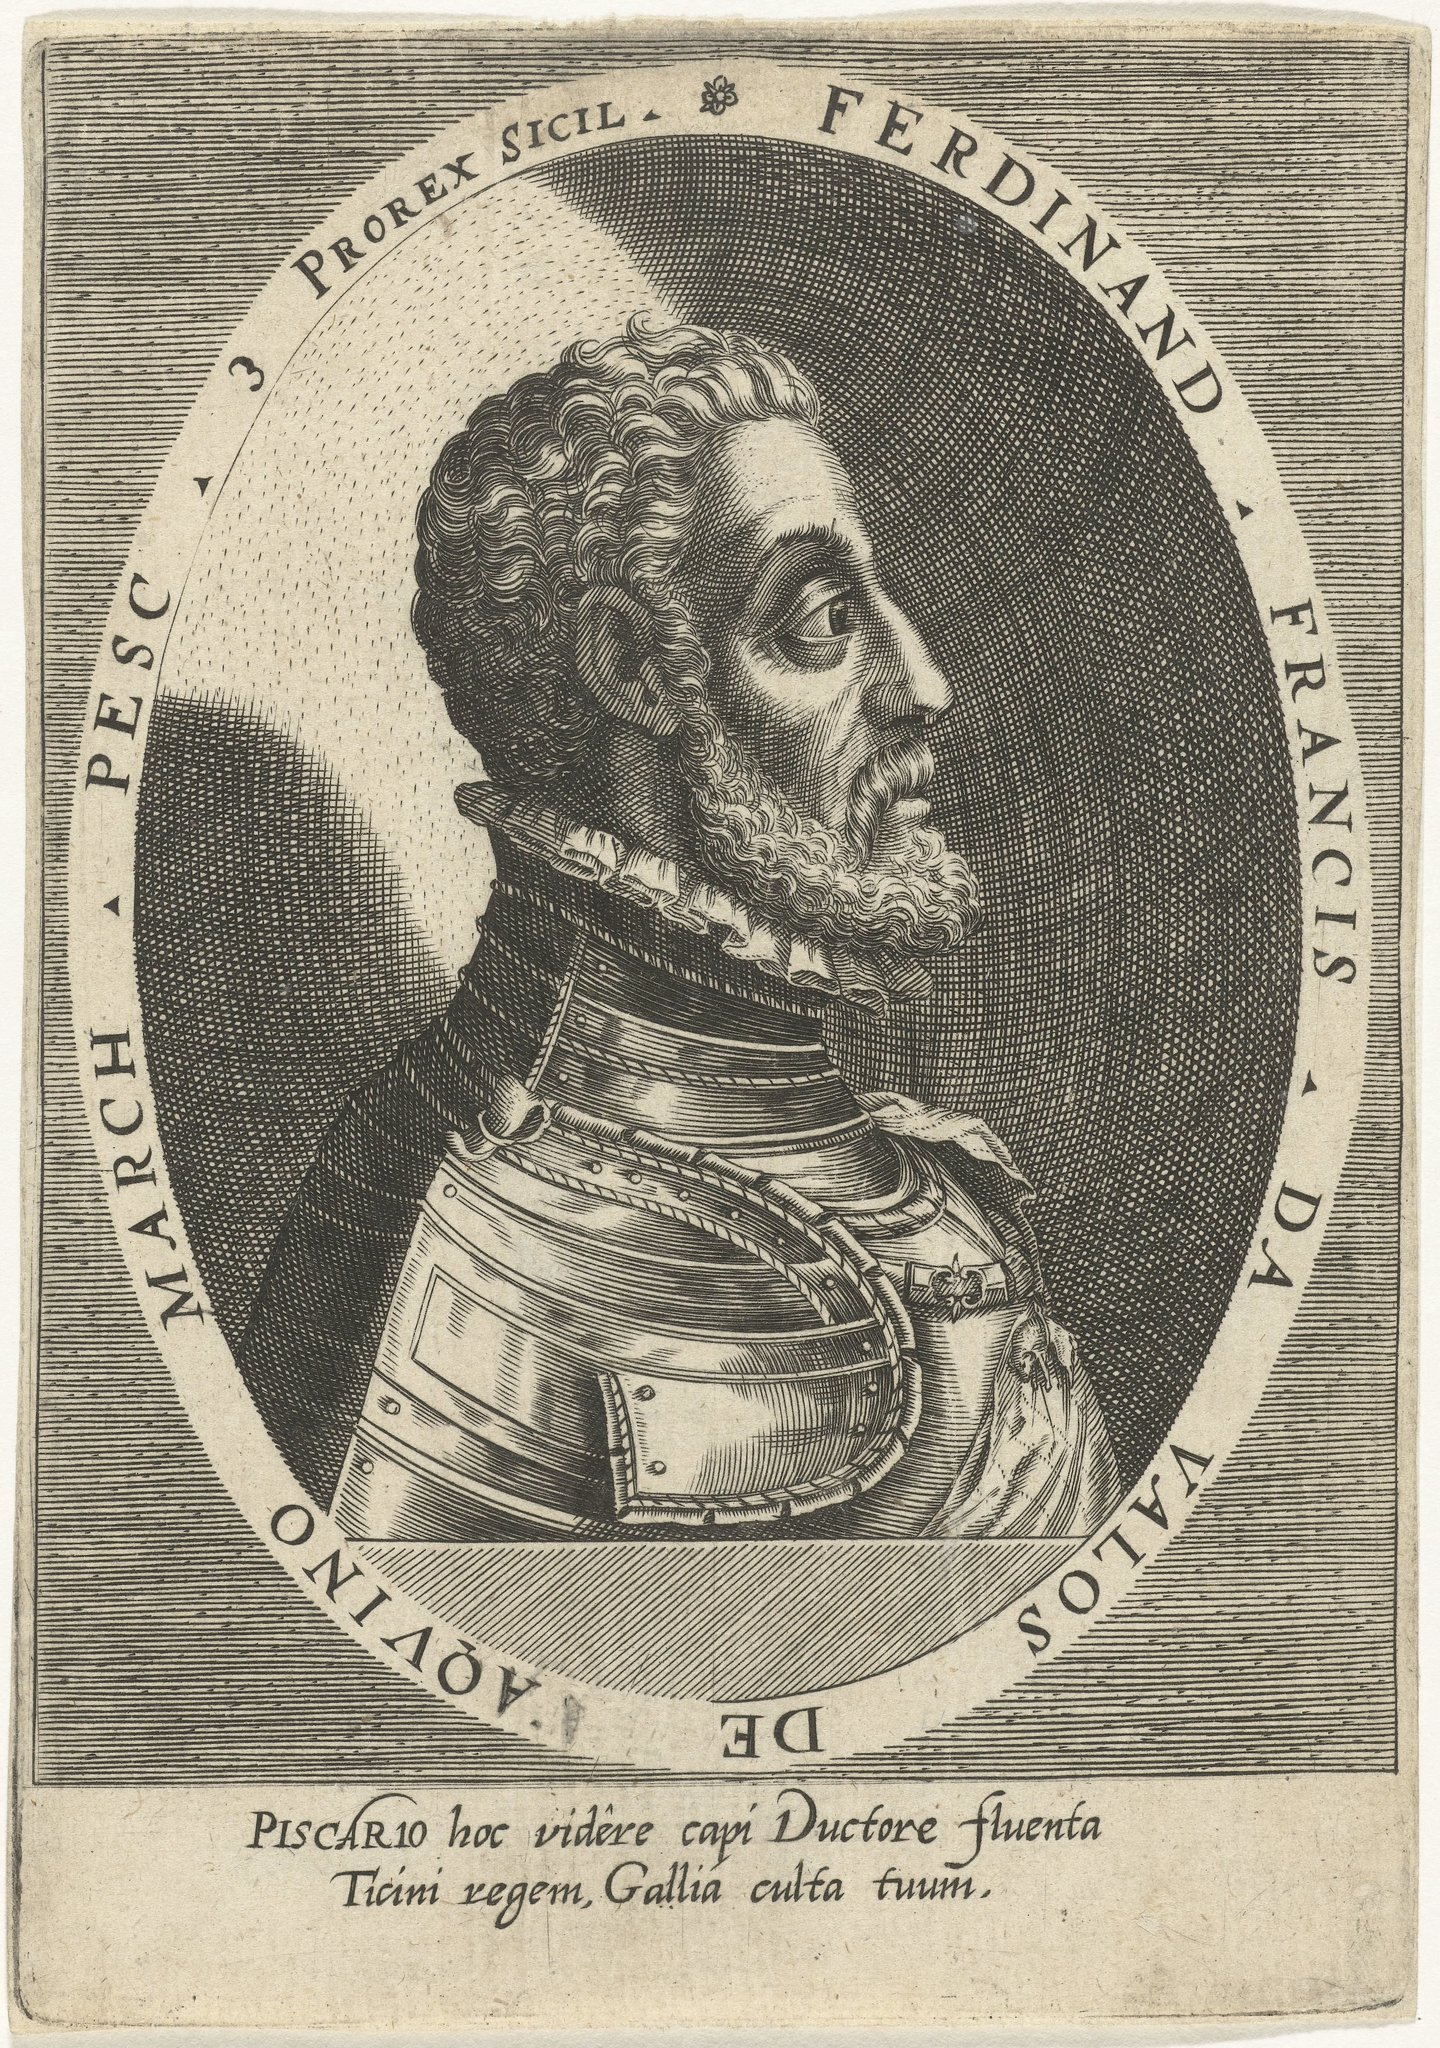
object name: print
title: Atrium Heroicum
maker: dominicus custos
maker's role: print maker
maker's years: 1560-1615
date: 1600-1604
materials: paper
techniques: engraving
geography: augsburg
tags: historical persons, knighthood order of the golden fleece - insignia of a knighthood order, e.g.: badge, chain (with name of order)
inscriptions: collector's mark: Lugt 2228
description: Illustratie uit: D. Custos en M. Henning. Atrium heroicum Caesarum, regum aliorq. summatum ac procerum qui intra proximum seculum vixere, aut hodie supersunt, imaginib. Deel 1-4. Augsburg: D. Custos, 1600-1604.